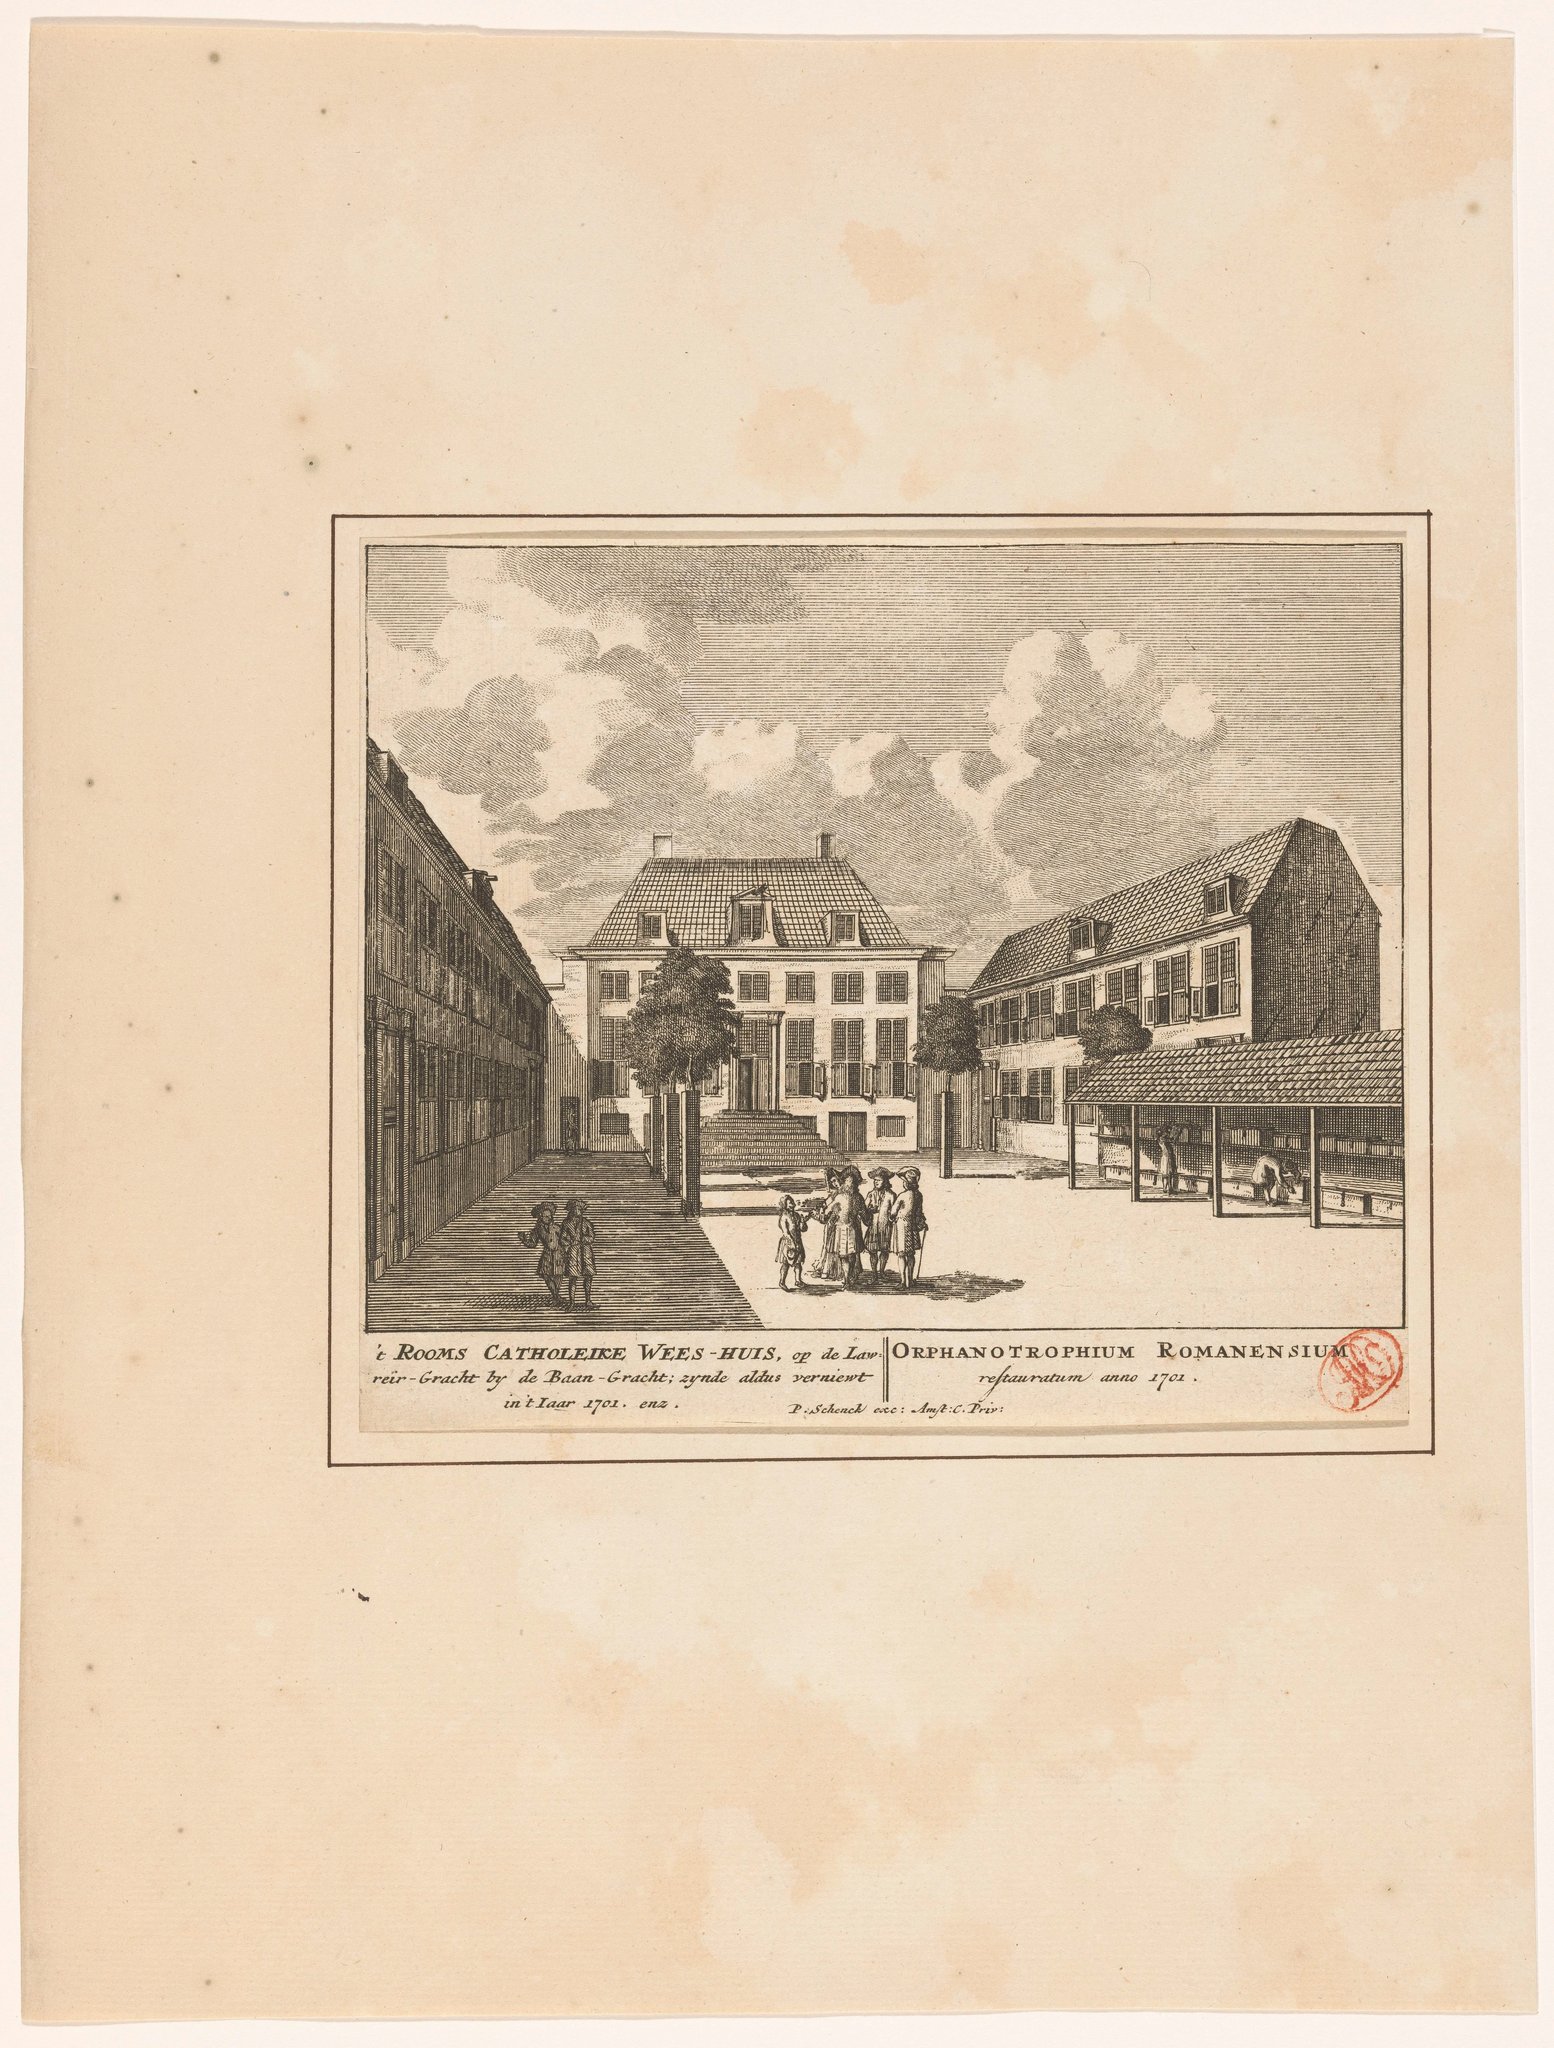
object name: print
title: Gezicht op het Rooms-Katholiek Jongensweeshuis aan de Lauriergracht te Amsterdam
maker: Anonymous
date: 1710-1711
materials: paper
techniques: engraving, etching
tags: orphanage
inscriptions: collector's mark: Lugt 195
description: Genummerde staat van prent ook gebruikt in: 100 Afbeeldinge der voornaamste gebouwen van Amsterdam. Amsterdam, Pieter Schenk (I), s.a. [1710-1711]. En in: 100 Afbeeldinge der voornaamste gebouwen van Amsterdam. Amsterdam, Barent Greve, s.a. [1757-1766].* *In de tweede uitgave, uitgegeven door Barent Greve, is alleen de titelprent aangepast. De overige prenten zijn onveranderd gebleven.